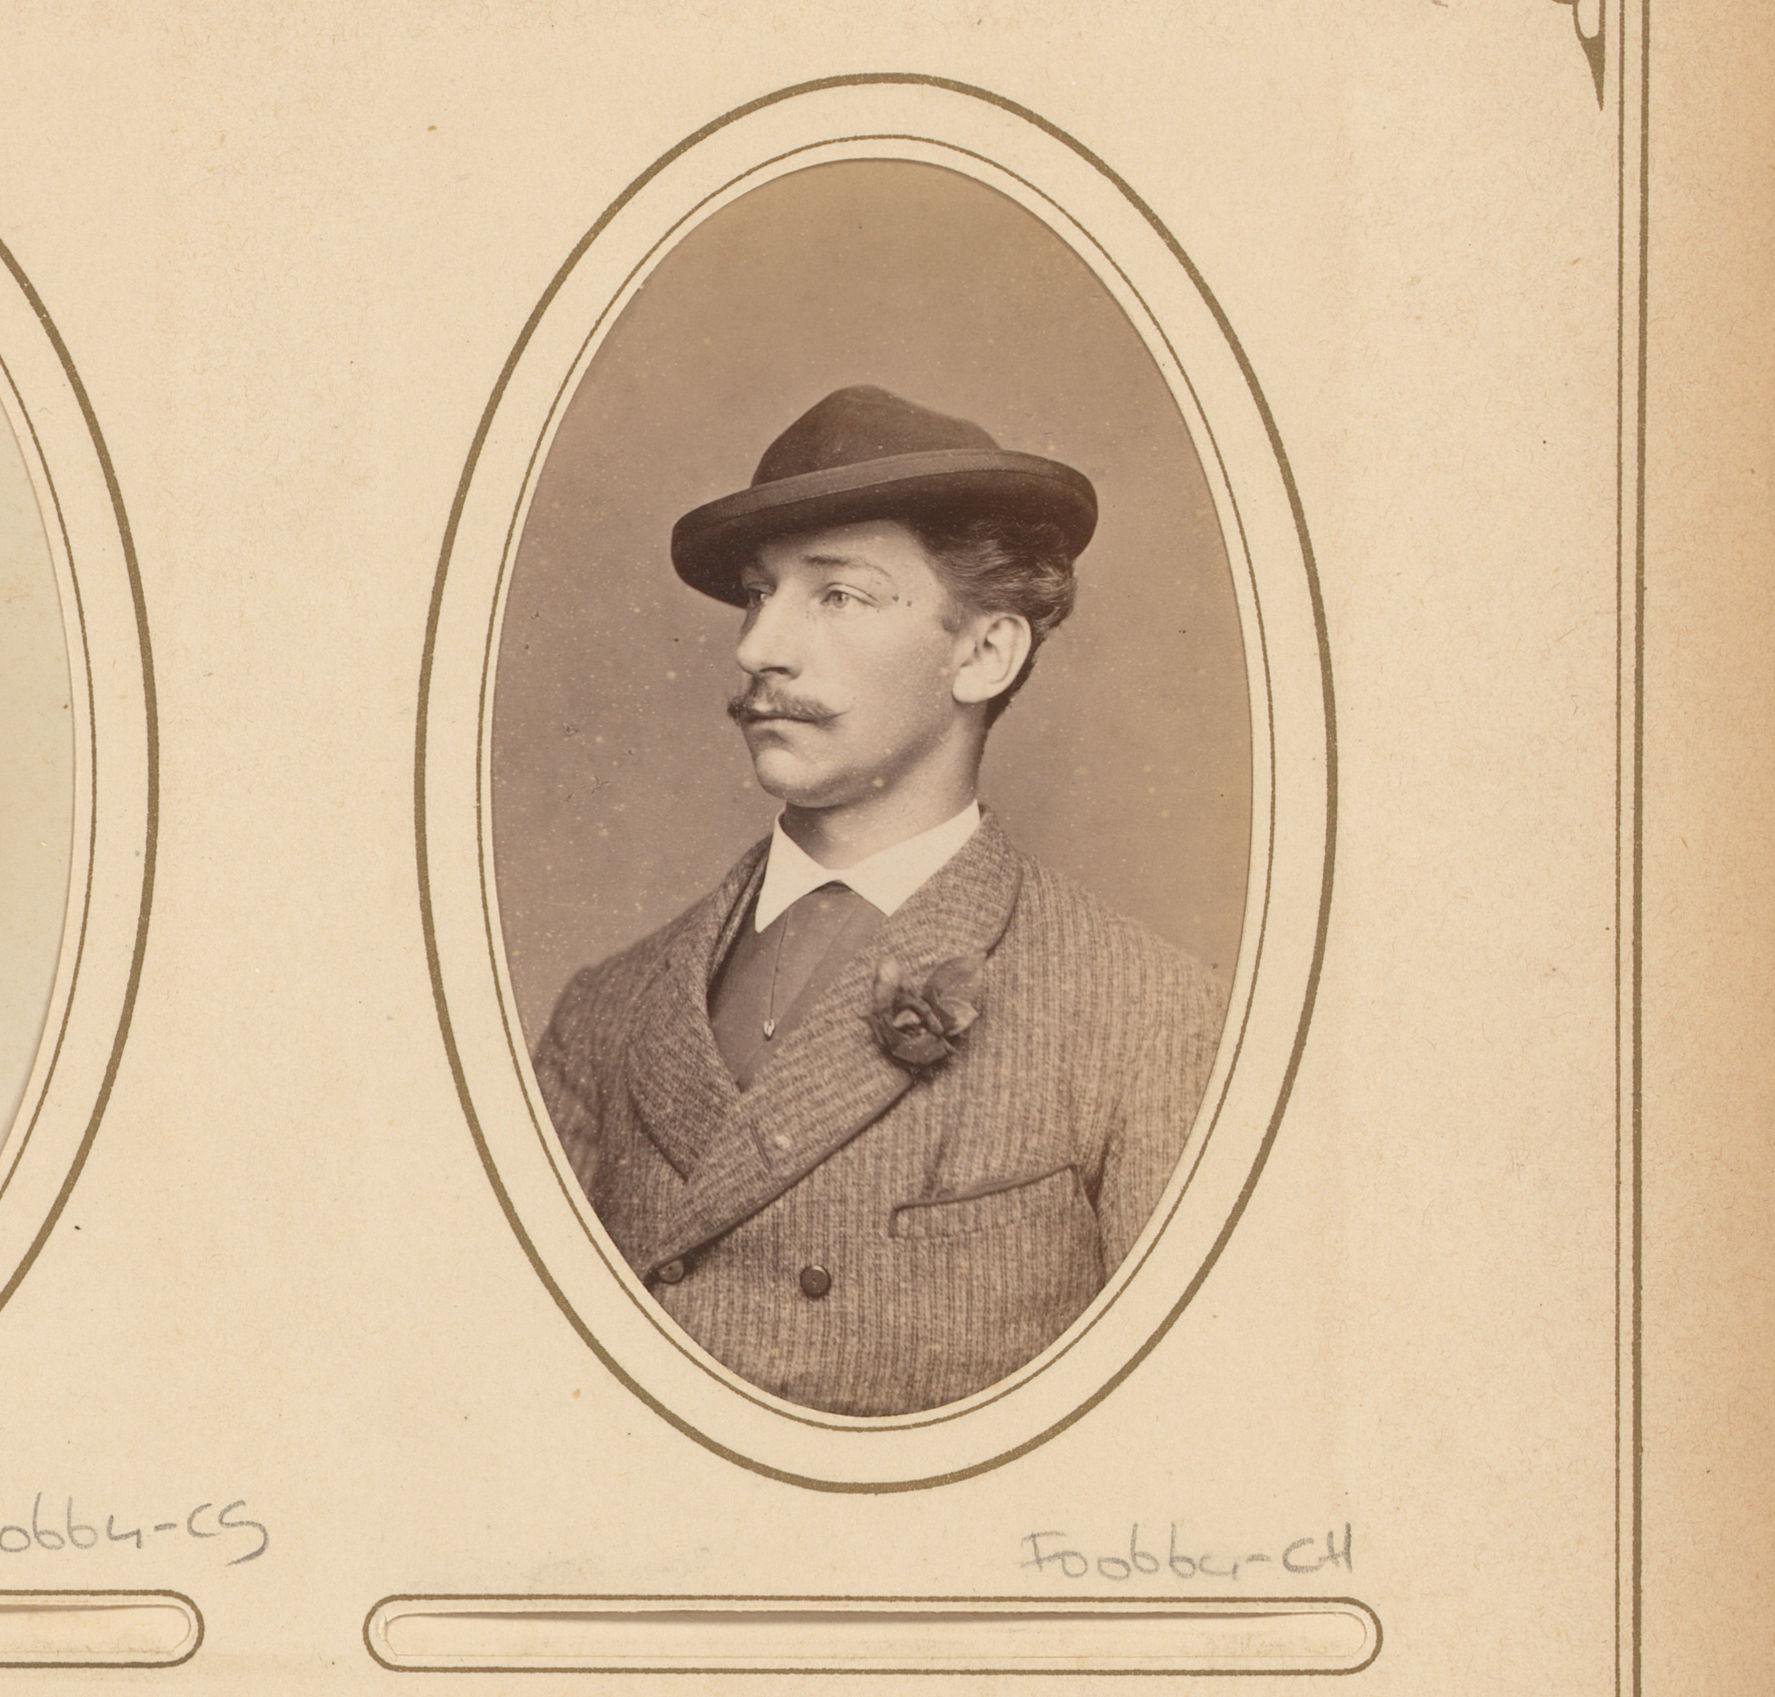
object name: album leaf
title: Portret van een man met hoed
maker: f.e. perger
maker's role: fotograaf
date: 1860-1880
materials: cardboard, photographic support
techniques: albumen print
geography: bad ems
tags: historical persons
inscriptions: inscription: ‘Atelier für Photographie von F.E. Perger in Bad Ems/ Haus Kaiser Alexander’